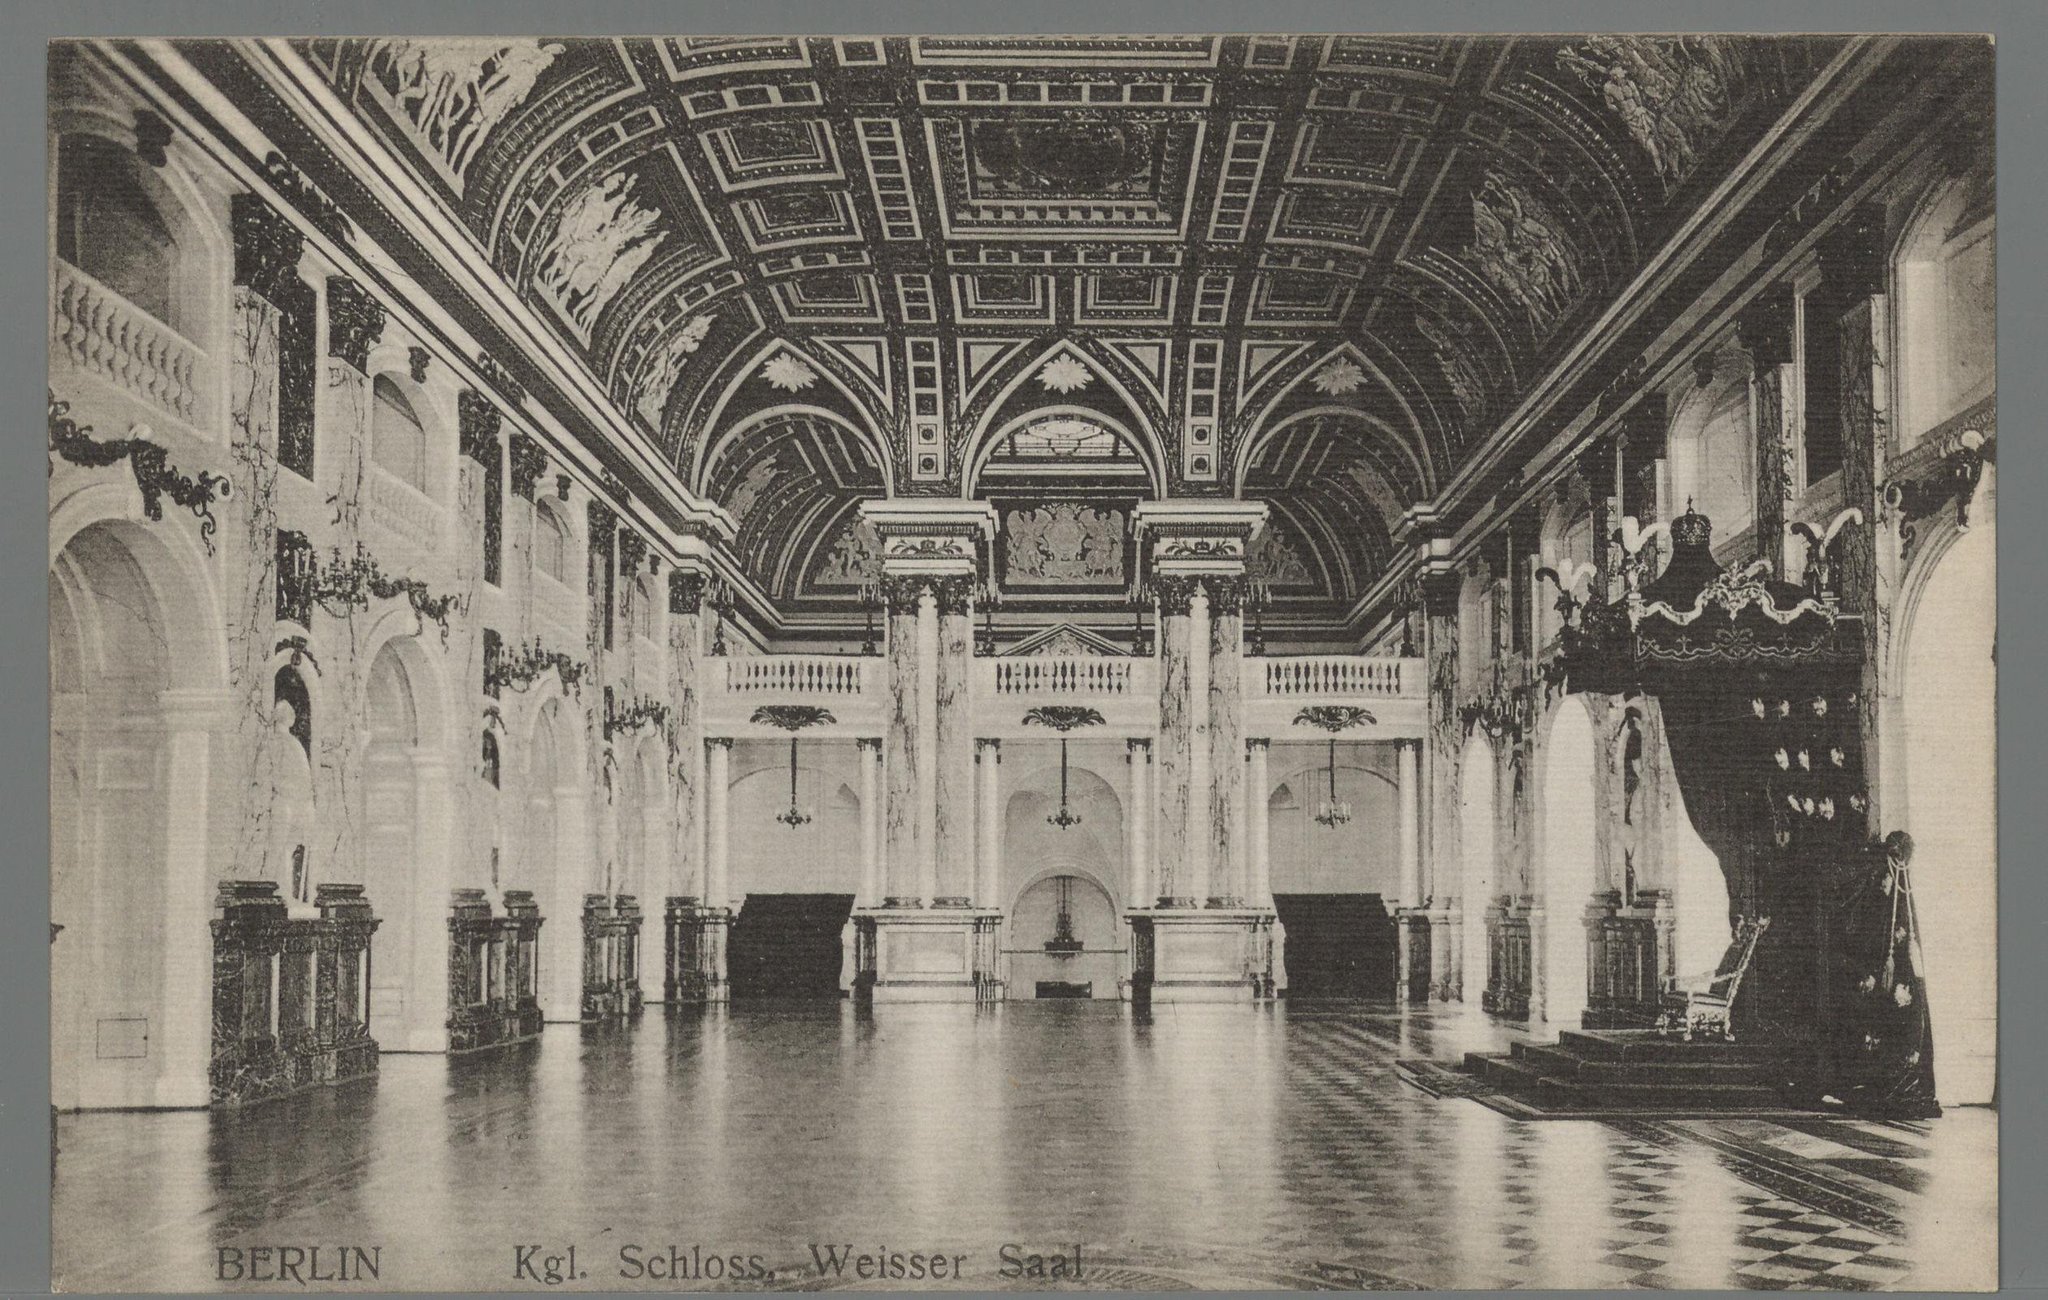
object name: ansichtkaart, prentbriefkaart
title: Berlin. Kgl. Schloss, Weisser Saal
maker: Anonymous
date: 1905-1930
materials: cardboard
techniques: photograph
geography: berlin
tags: castle, interior of the house